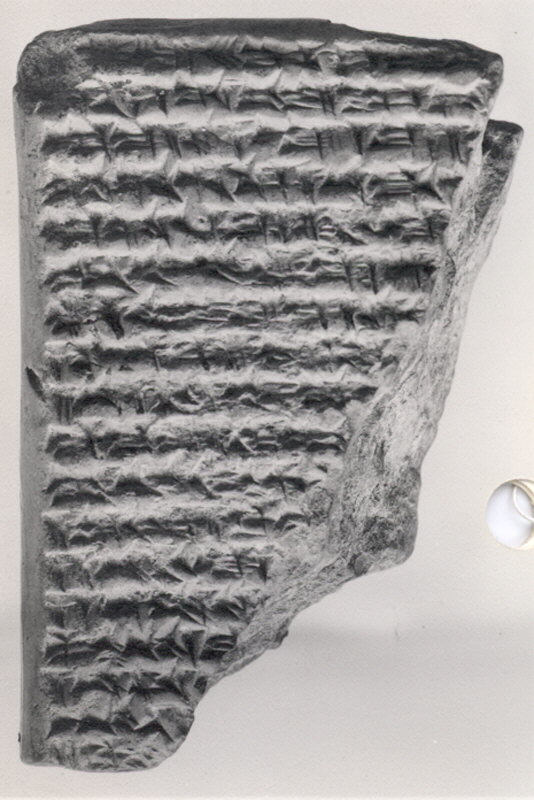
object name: cuneiform tablet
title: Cuneiform tablet: agreement regarding division of property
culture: achaemenid or babylonian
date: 700-301 BCE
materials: clay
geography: mesopotamia